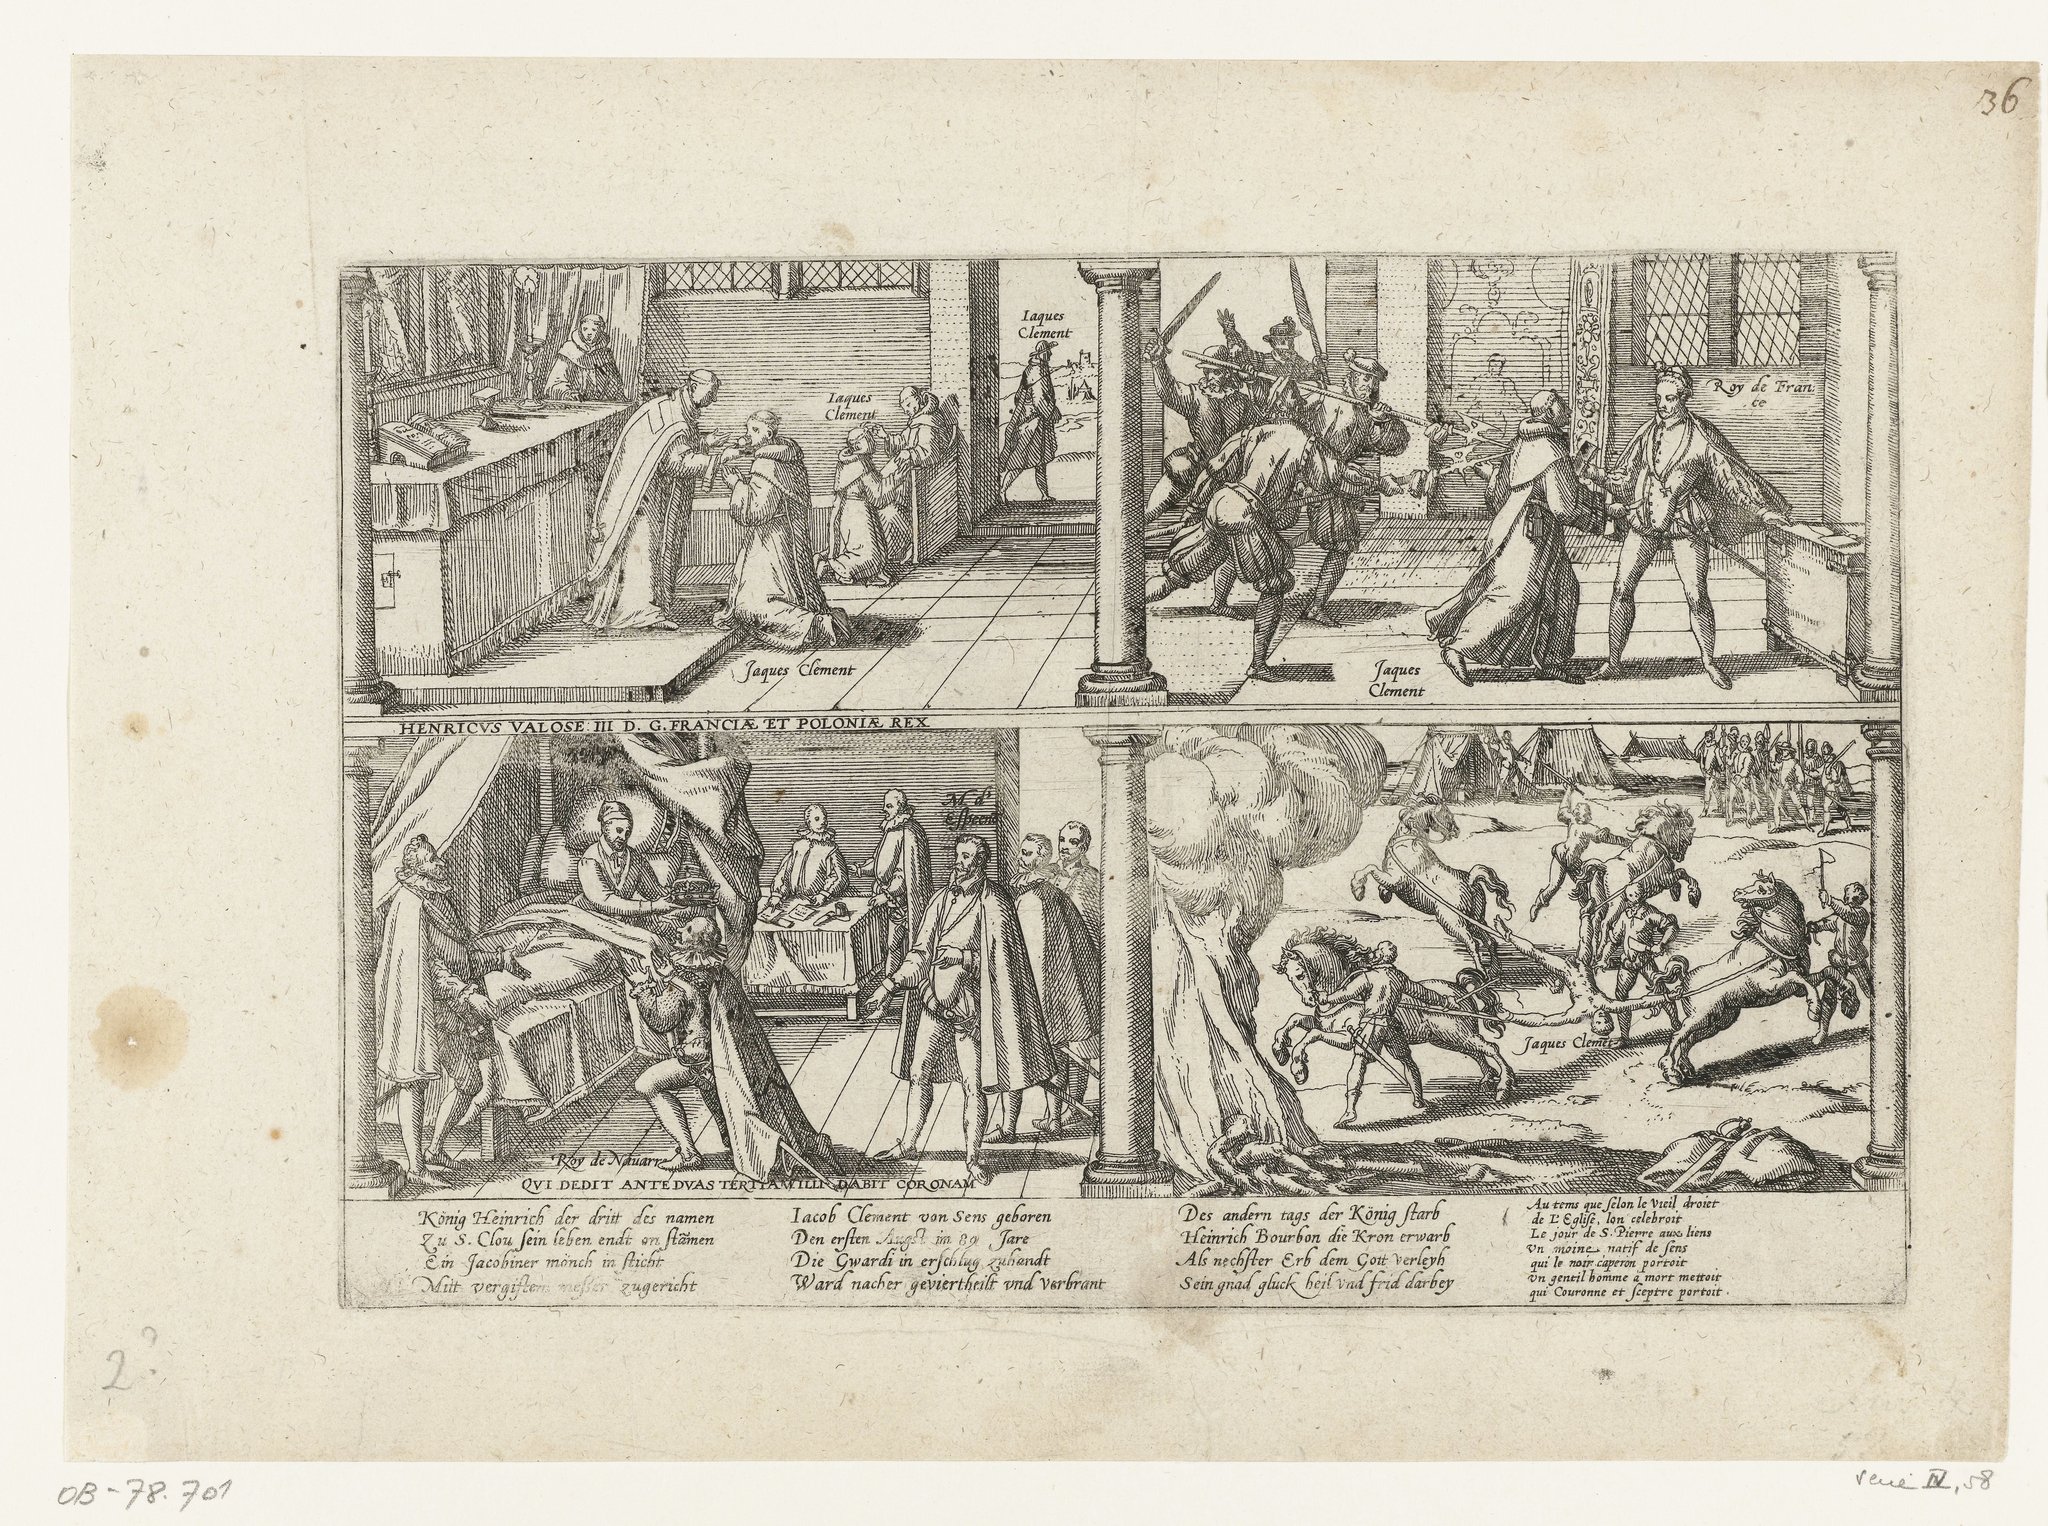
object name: print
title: Serie 4: Franse, Duitse en Engelse Gebeurtenissen, 1576-1610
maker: frans hogenberg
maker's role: print maker, publisher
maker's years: 1538-1590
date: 1589-1591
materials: paper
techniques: etching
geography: cologne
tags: hendrik iii (koning van frankrijk), paris, hendrik iv (koning van frankrijk en navarra), violent death by quartering, coronation of a ruler, attempt, political murder